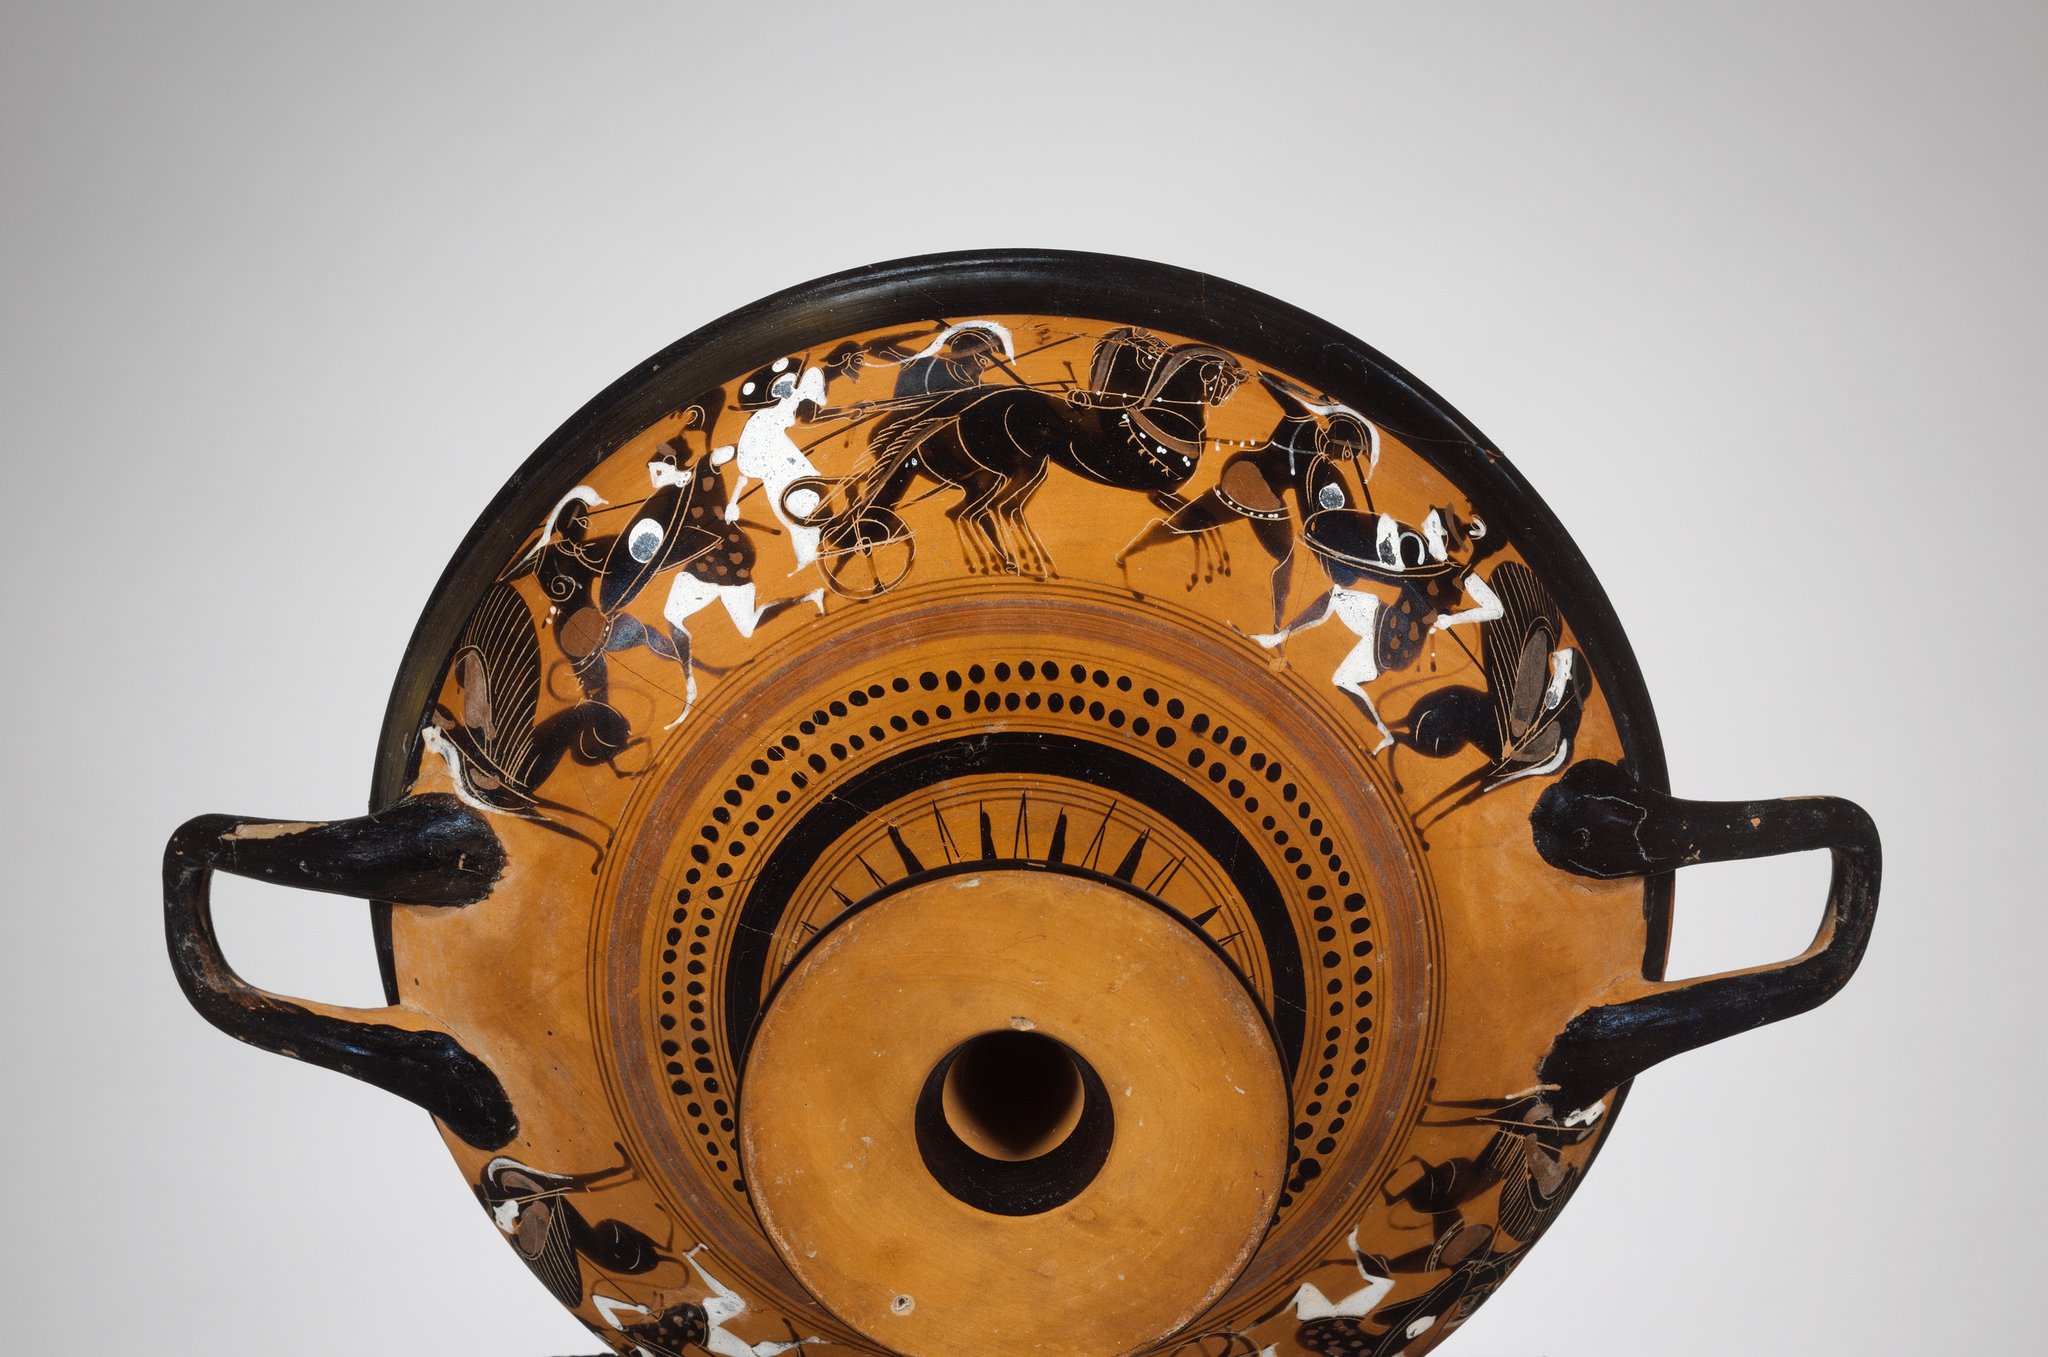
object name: kylix, droop cup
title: Terracotta kylix: Droop cup (drinking cup)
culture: greek, attic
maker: group of rhodes 12264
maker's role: artist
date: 540 BCE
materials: terracotta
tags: battles,soldiers,sphinx,chariots